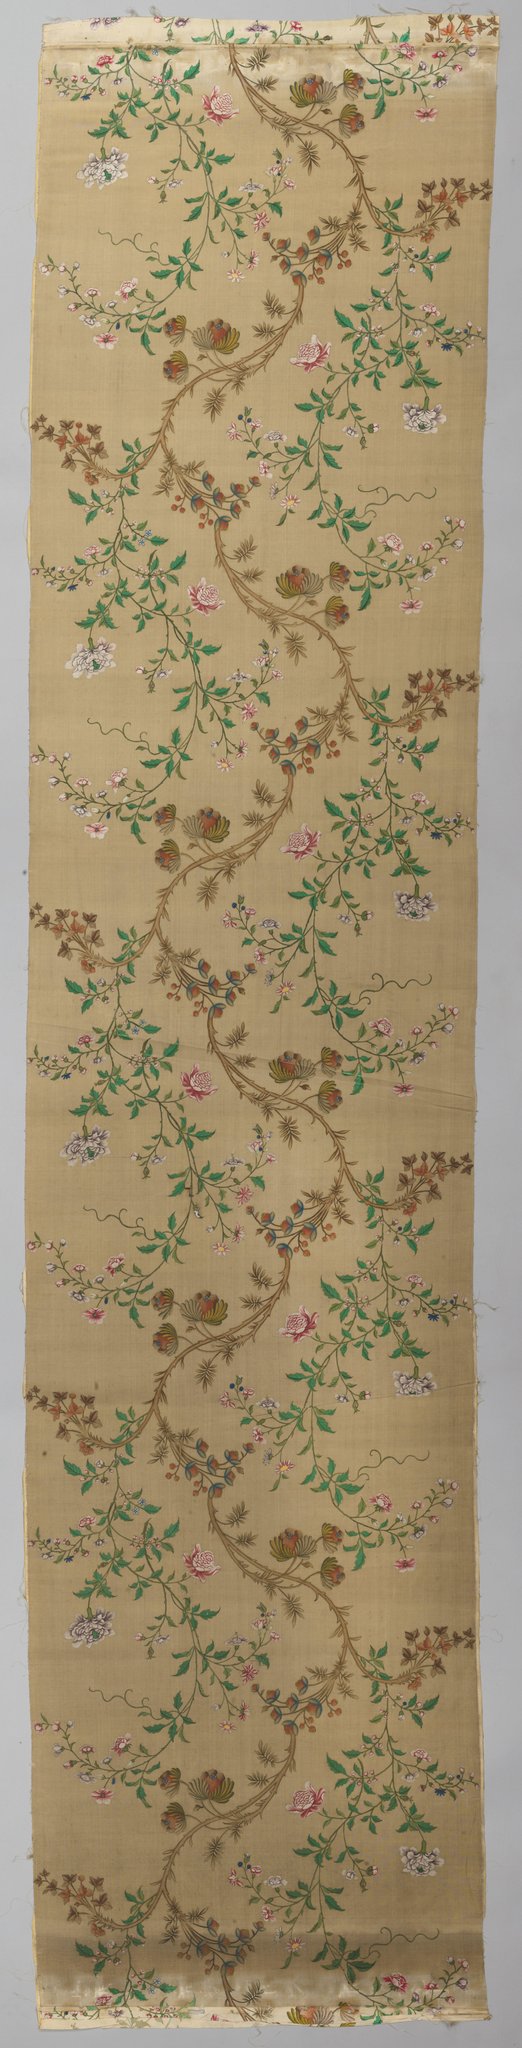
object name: upholstery fabric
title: Bespanningsstof met decor van takken, bladeren, bloemen en vruchten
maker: Anonymous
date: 1750-1790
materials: paint, silk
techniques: printing, weave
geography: china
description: Een baan veelkleurig beschilderde creme bespanningsstof van zijde. Zie beschrijving A.